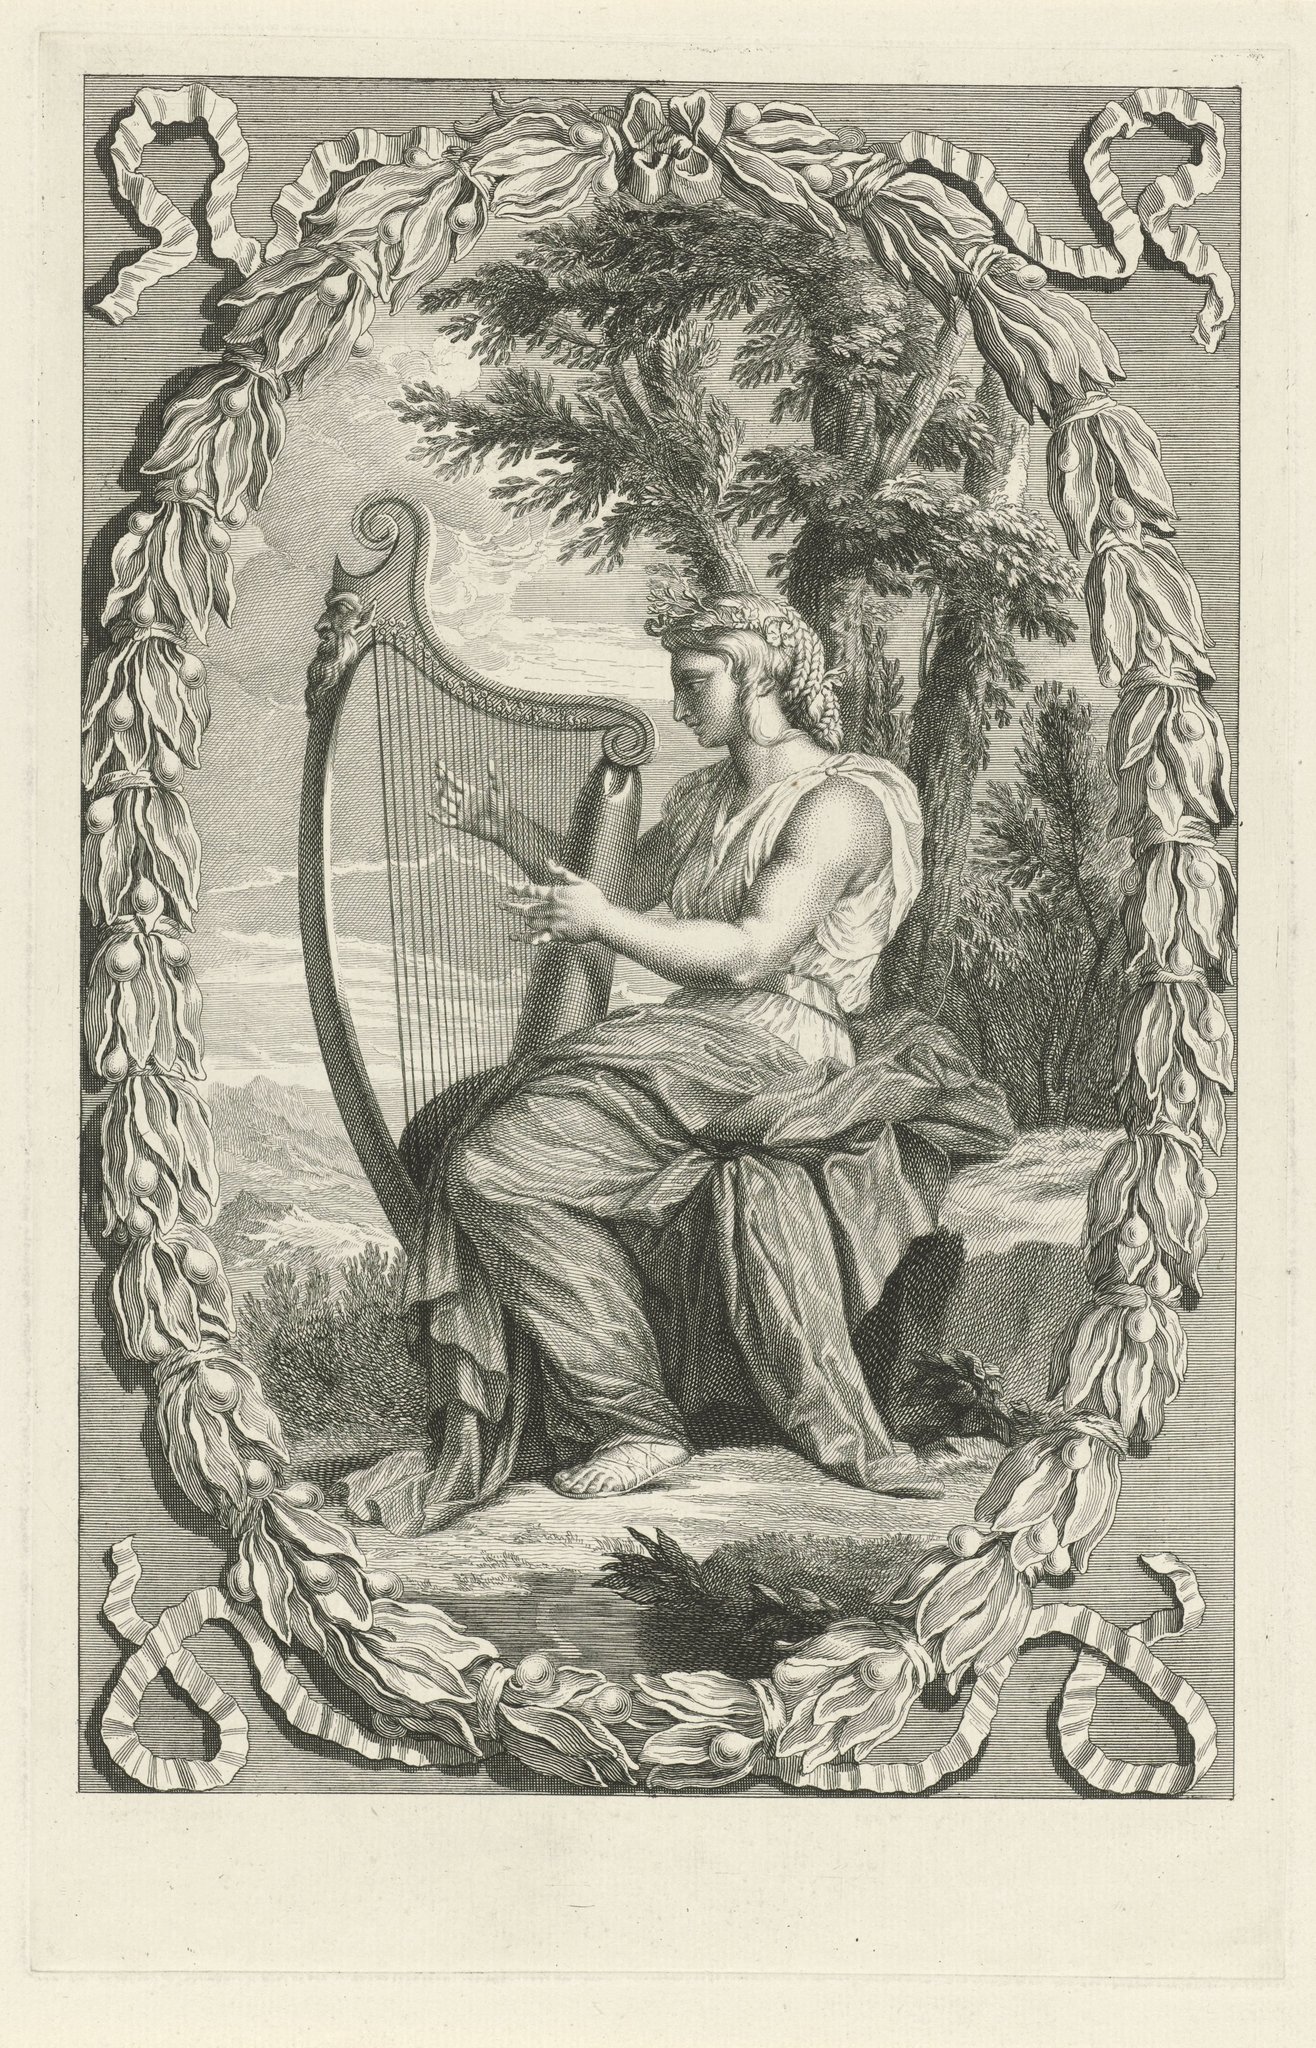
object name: print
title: Landschap met een musicerende muze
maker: bernard picart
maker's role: draughtsman, print maker, publisher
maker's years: 1673-1733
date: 1683-1733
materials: paper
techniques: engraving, etching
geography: paris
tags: (story of the) muses; 'muse' (ripa), harp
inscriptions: collector's mark: Lugt 2228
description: Landschap met een muze (Calliope?) die een harp bespeelt.